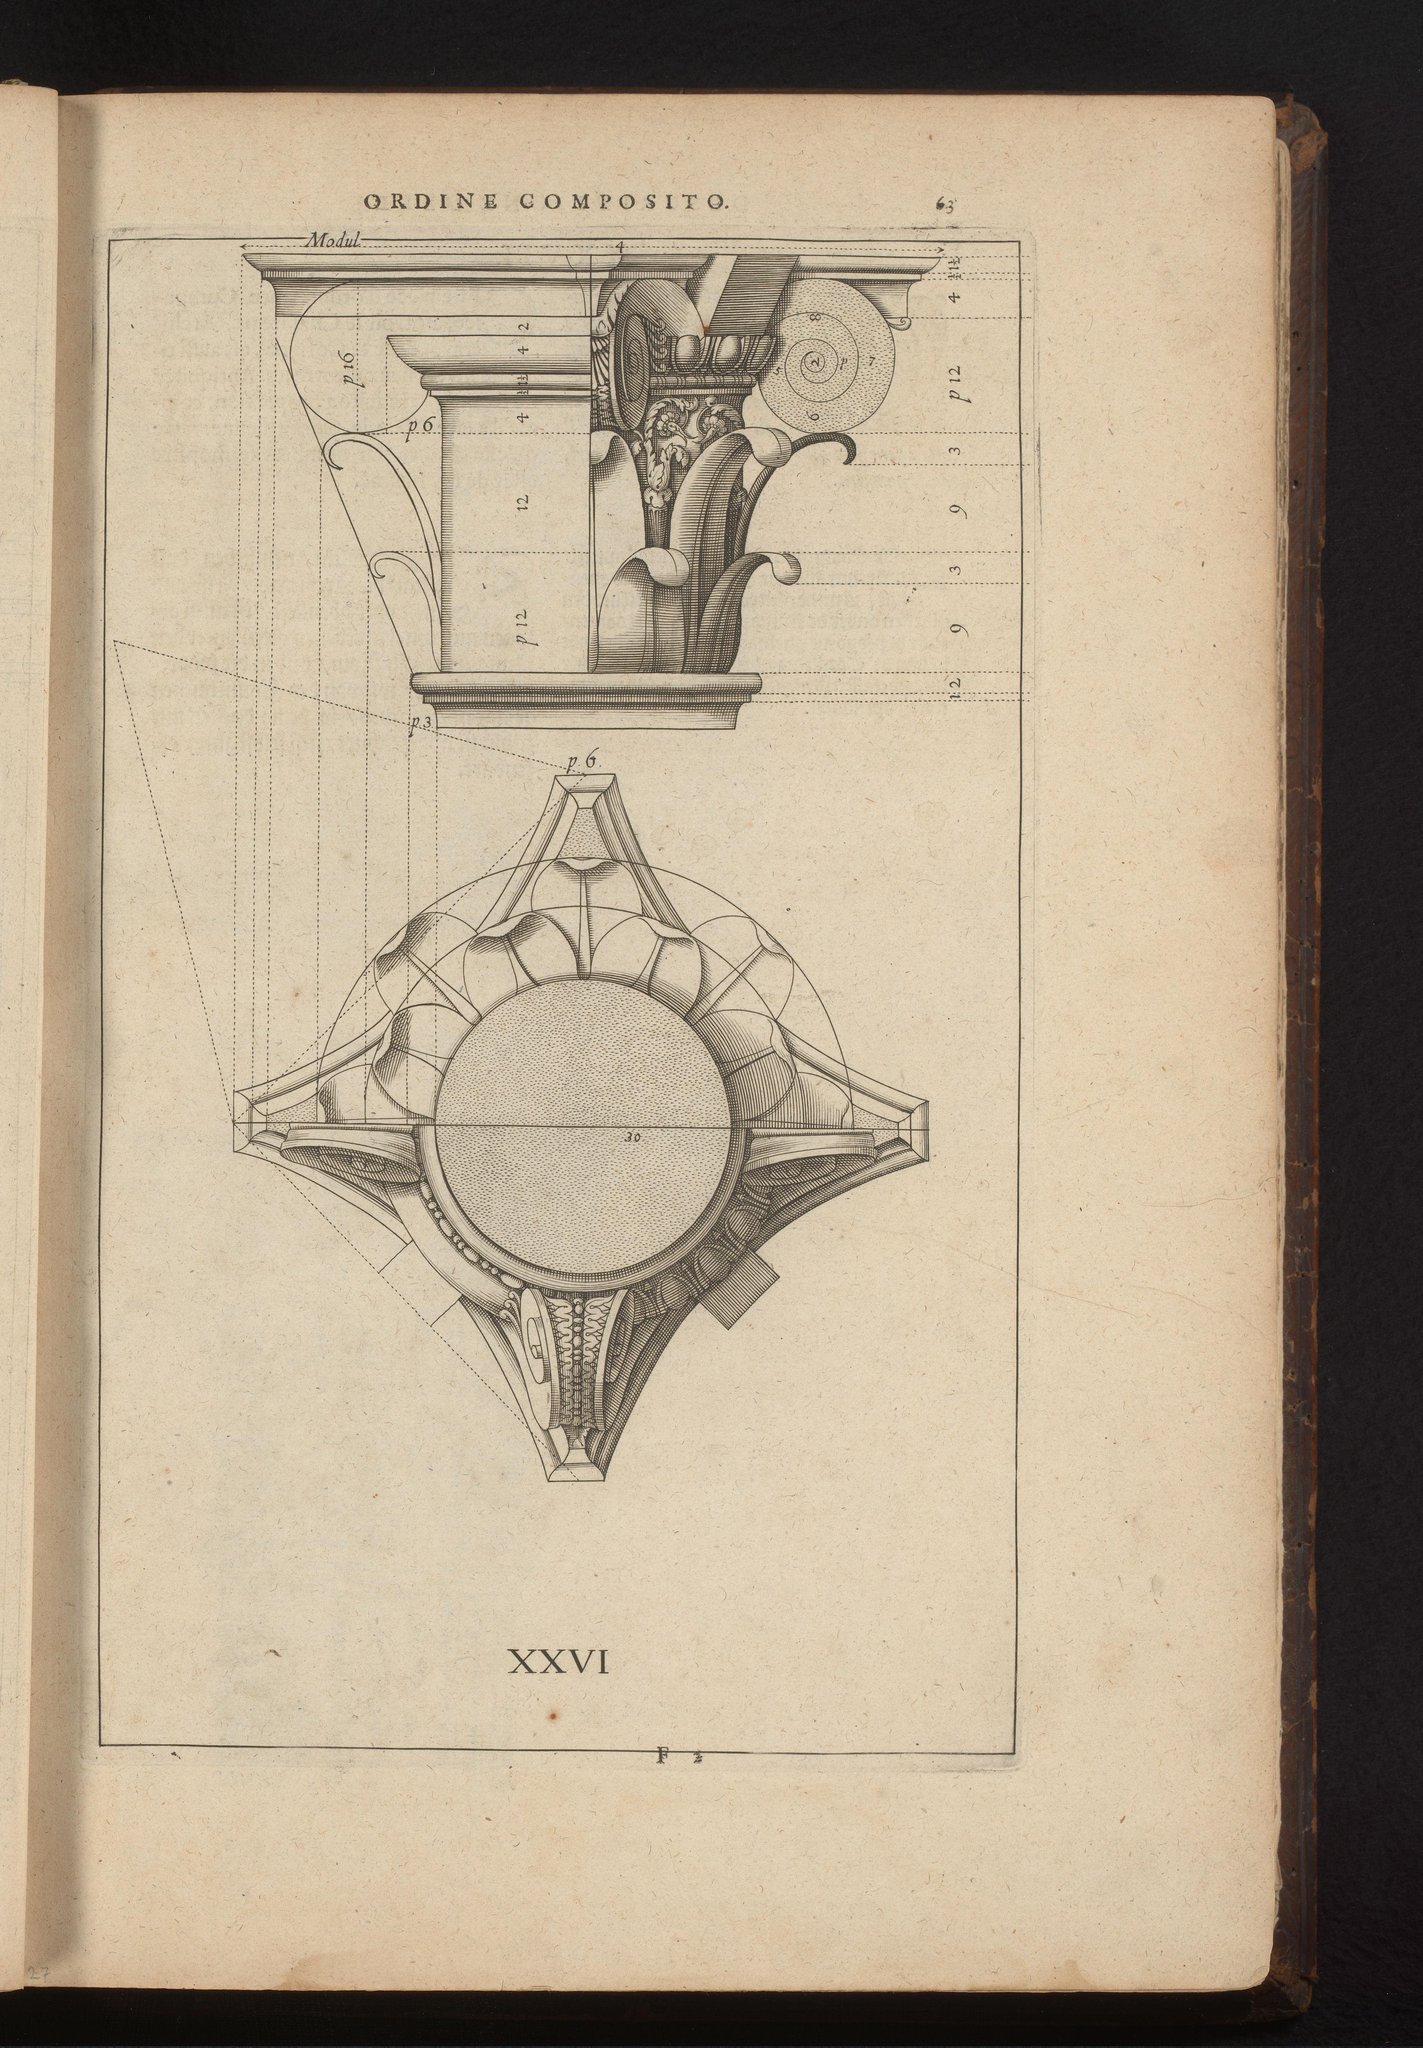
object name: book illustration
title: Composiet kapiteel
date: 1640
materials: paper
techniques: engraving, letterpress printing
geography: amsterdam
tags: composite order ~ architecture, orders, order-books ~ architecture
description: Prent uit: Vignola, Giacomo Barozzi da. Regola delli cinque ordini d'architettura (...). Amsterdam: Johannes Willemszoon en Cornelis Blaeu, 1640, p. 63.